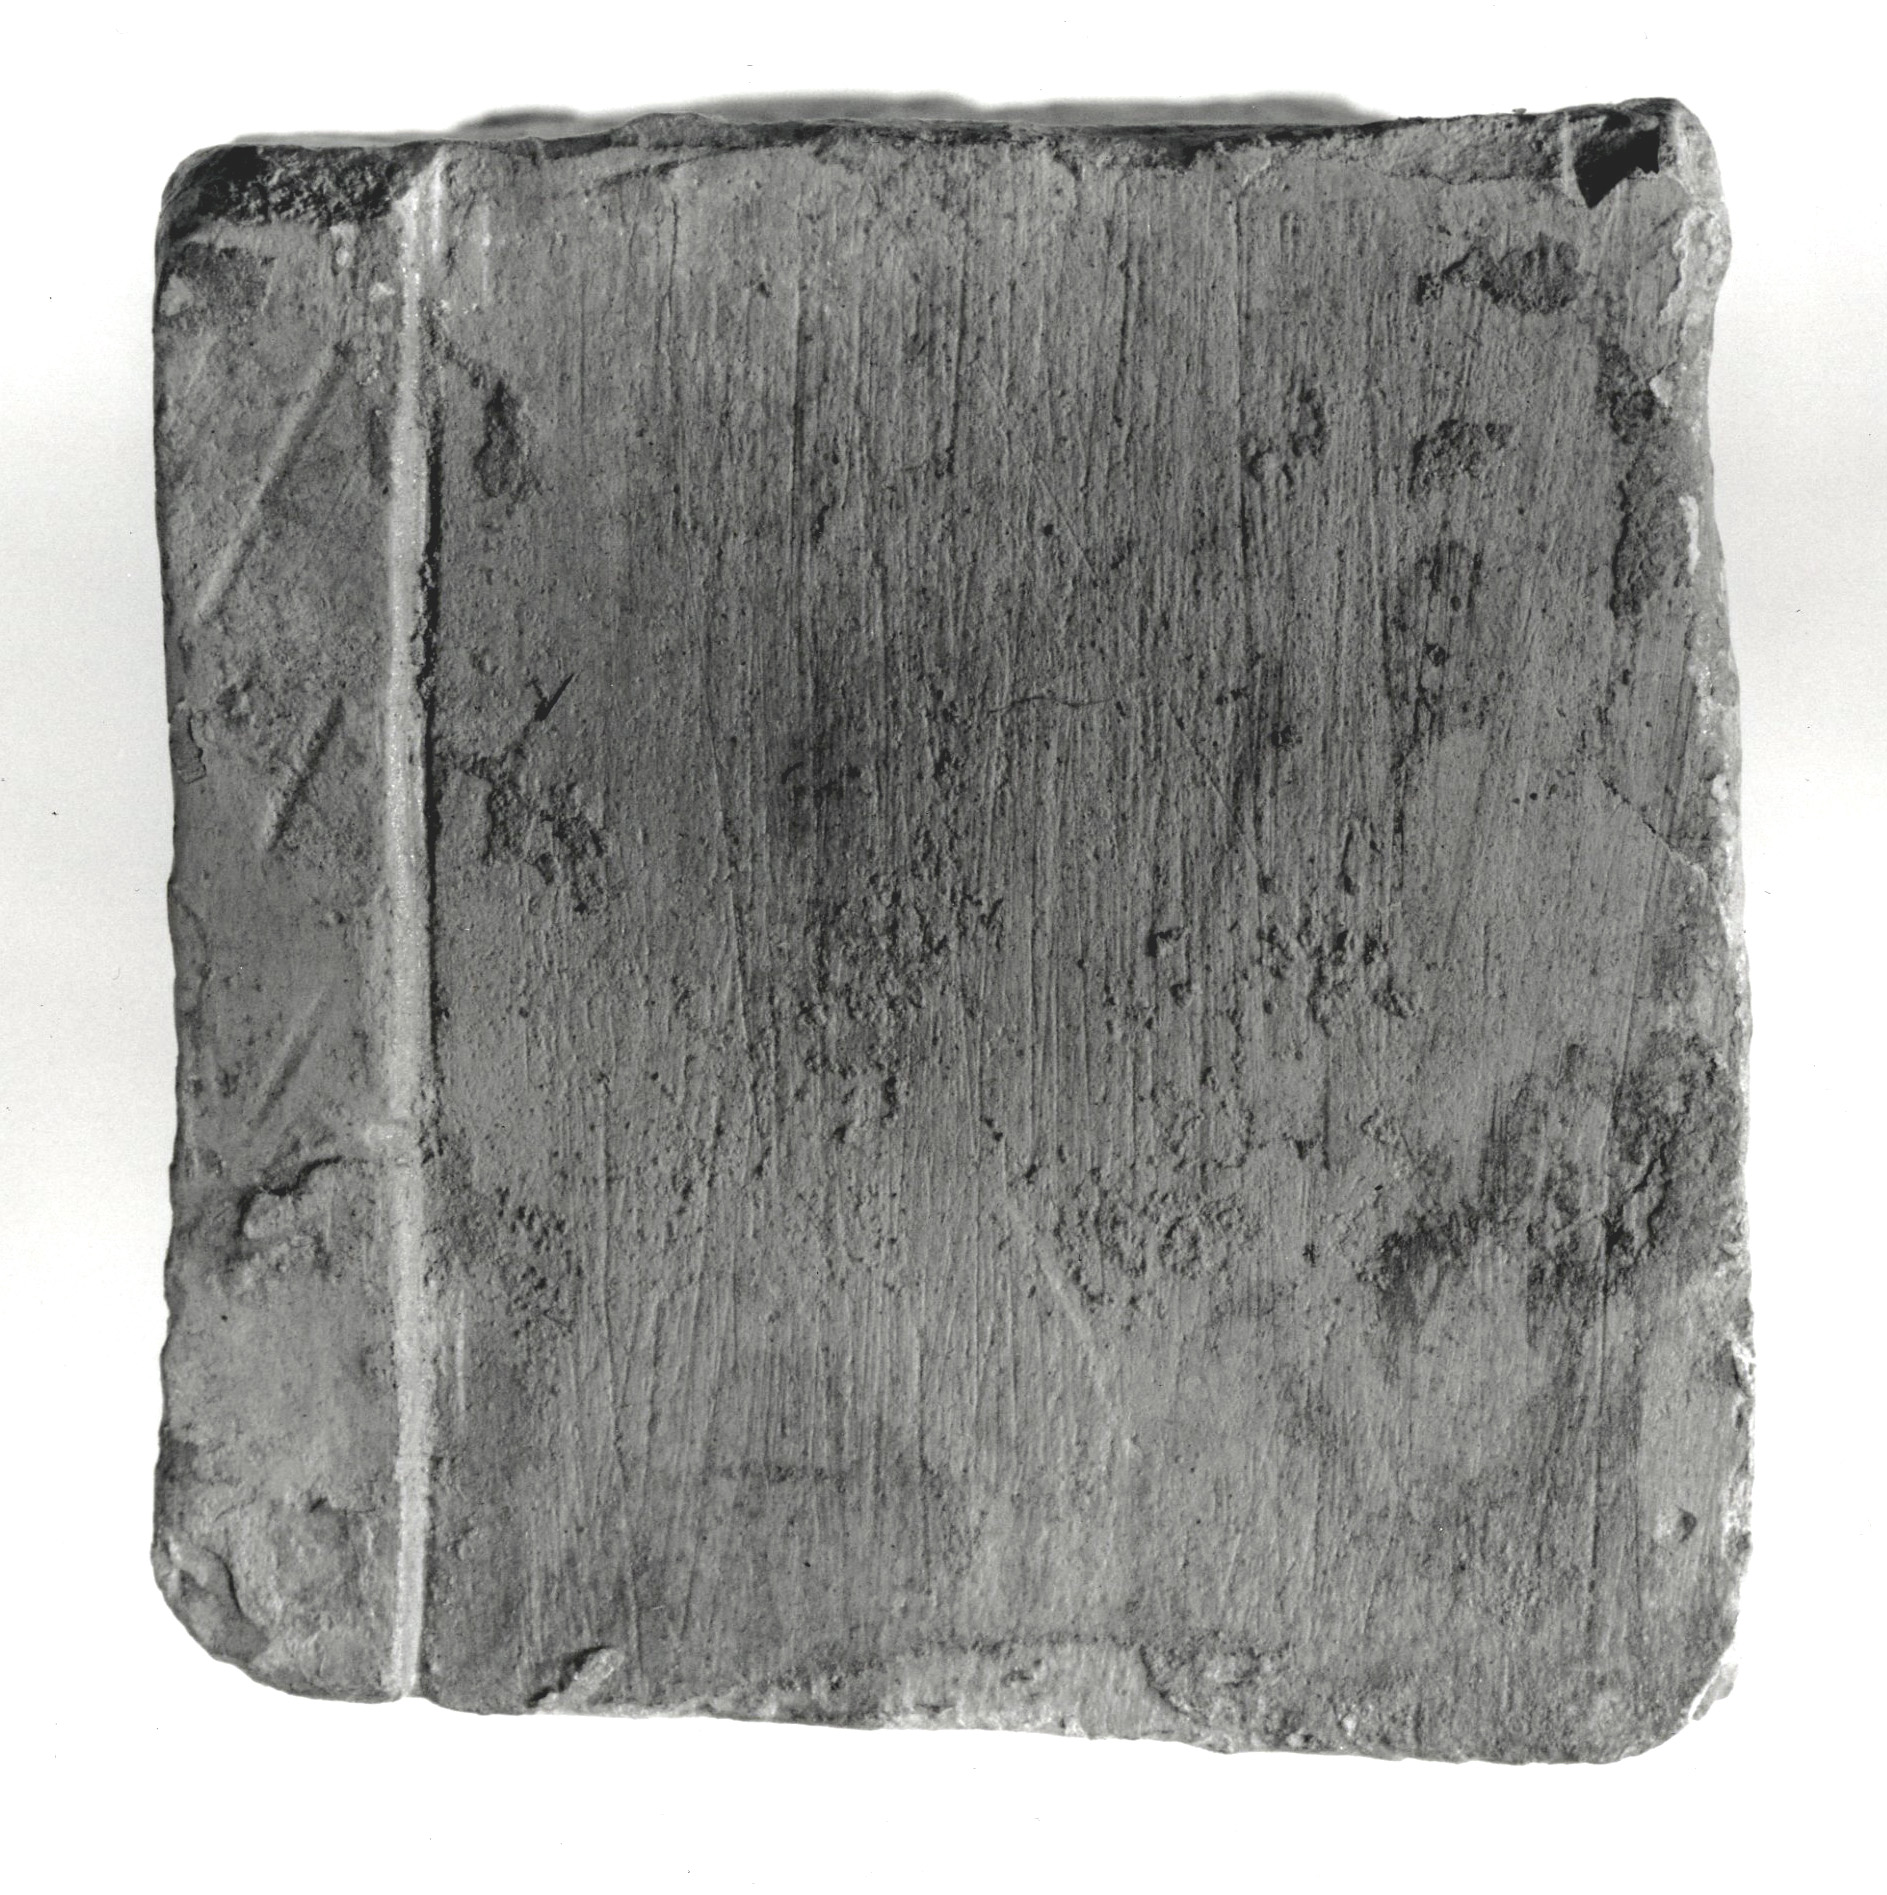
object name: relief, tomb of nespekashuty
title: Raised relief fragment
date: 664-610 BCE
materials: limestone, varnish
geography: egypt